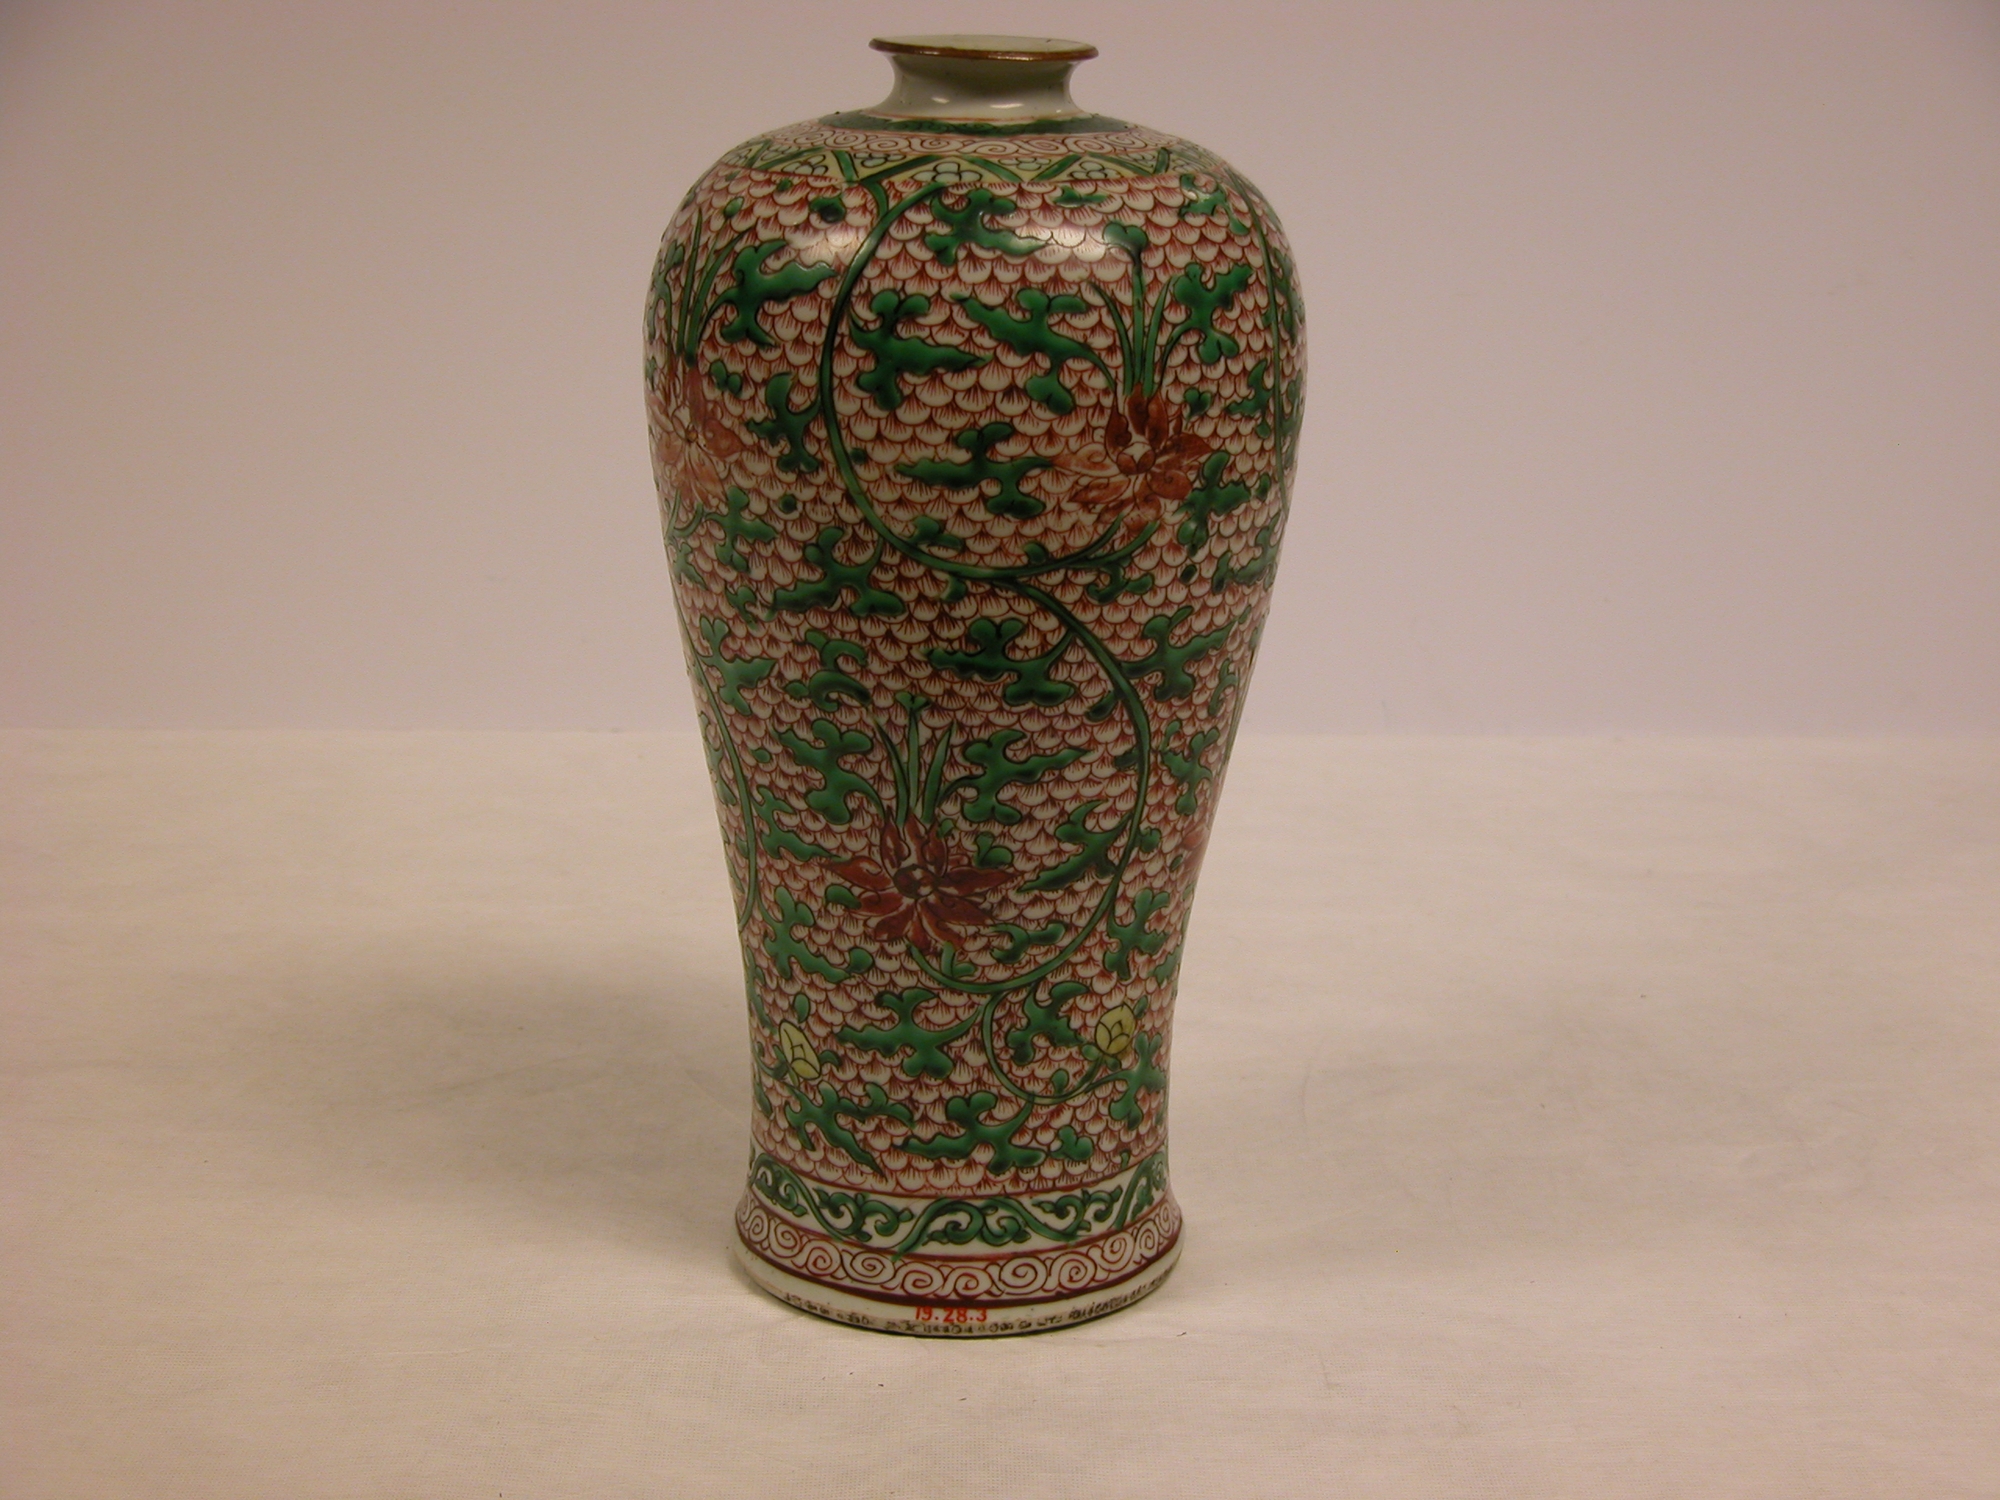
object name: vase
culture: chinese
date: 1600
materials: enamel, porcelain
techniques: overglaze, painting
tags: flowers